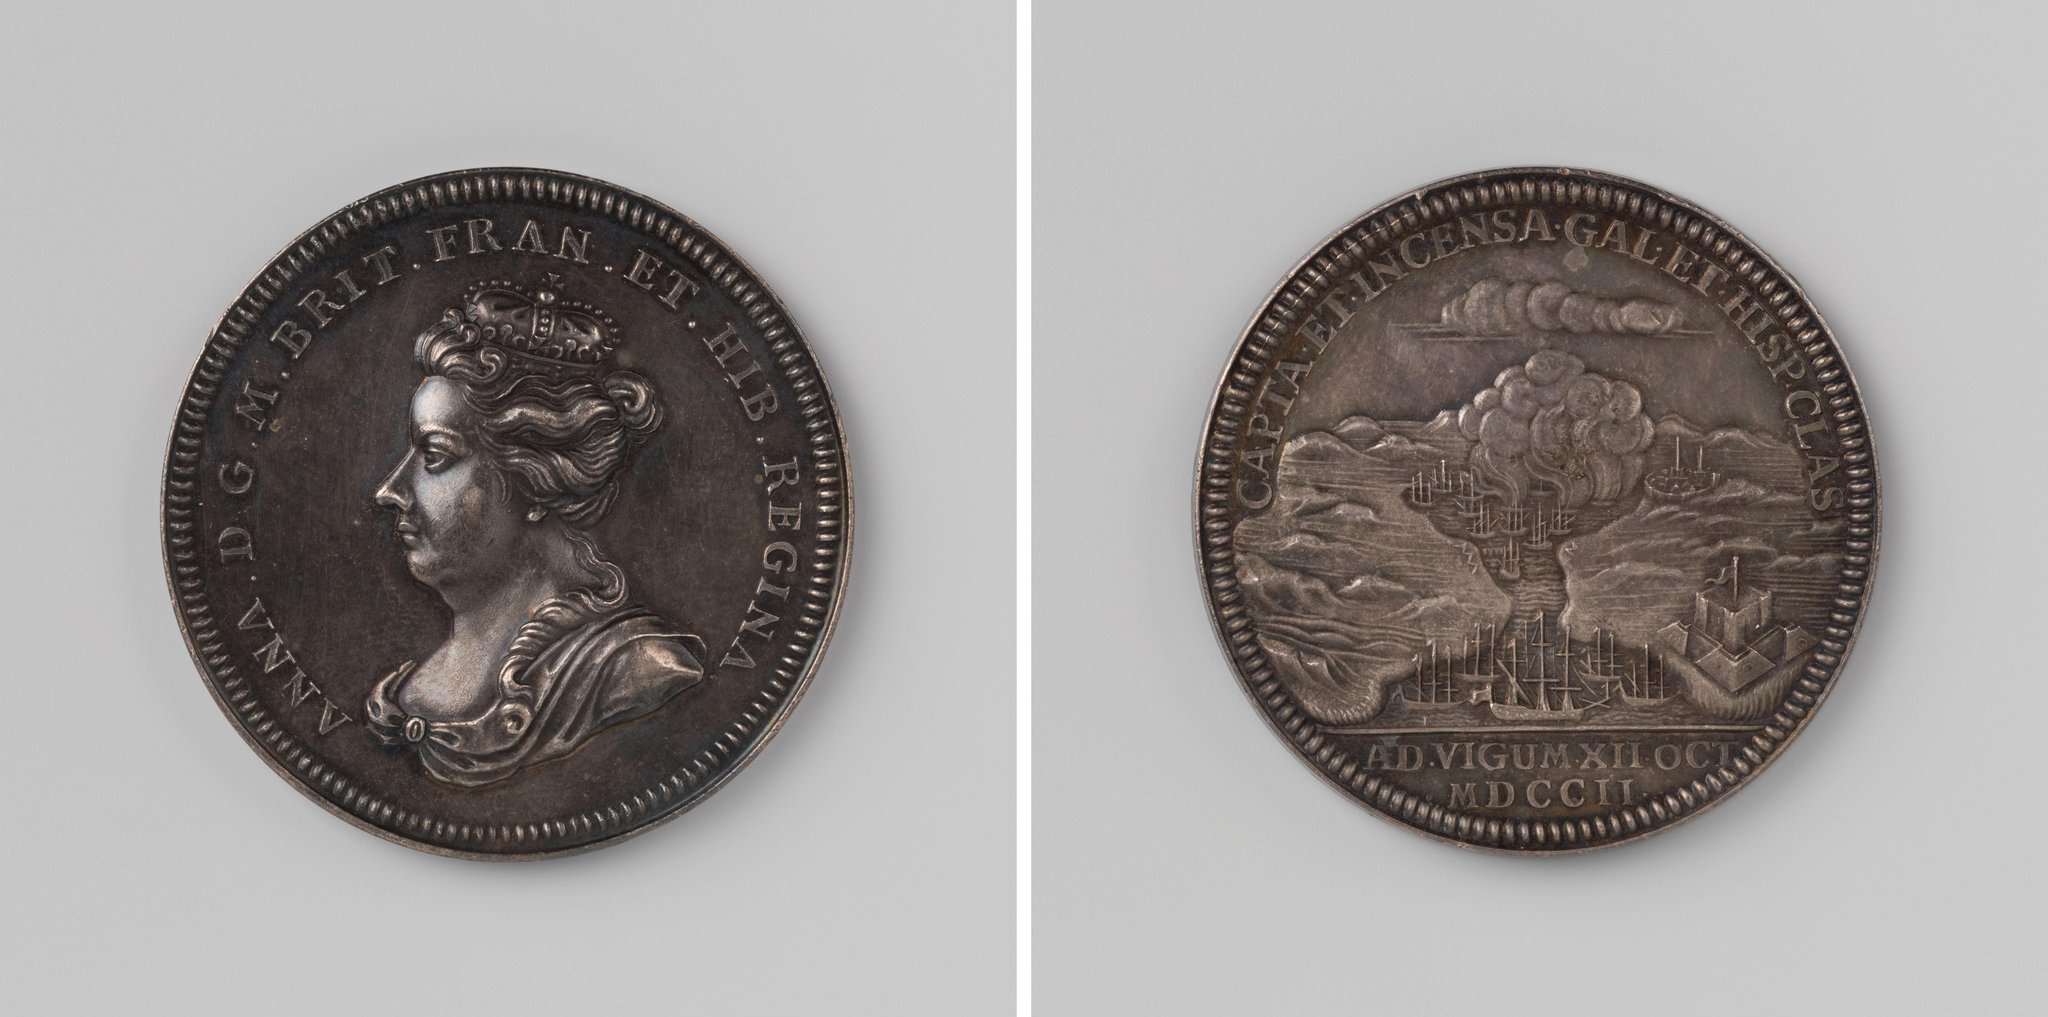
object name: history medal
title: Zeeslag bij Vigo (Vigos): het verbranden van de Franse en Spaanse vloot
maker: christian wermuth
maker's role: medailleur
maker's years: 1661-1739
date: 1702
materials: silver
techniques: striking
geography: gotha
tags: london, anna stuart (koningin van engeland en schotland)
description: Zilveren penning. Voorzijde: borststuk vrouw met kroon binnen omschrift. Keerzijde: gezicht op baai van Vigo met brandende schepen; Engels-Nederlandse vloot liggend aan monding van baai binnen omschrift, boven opschrift